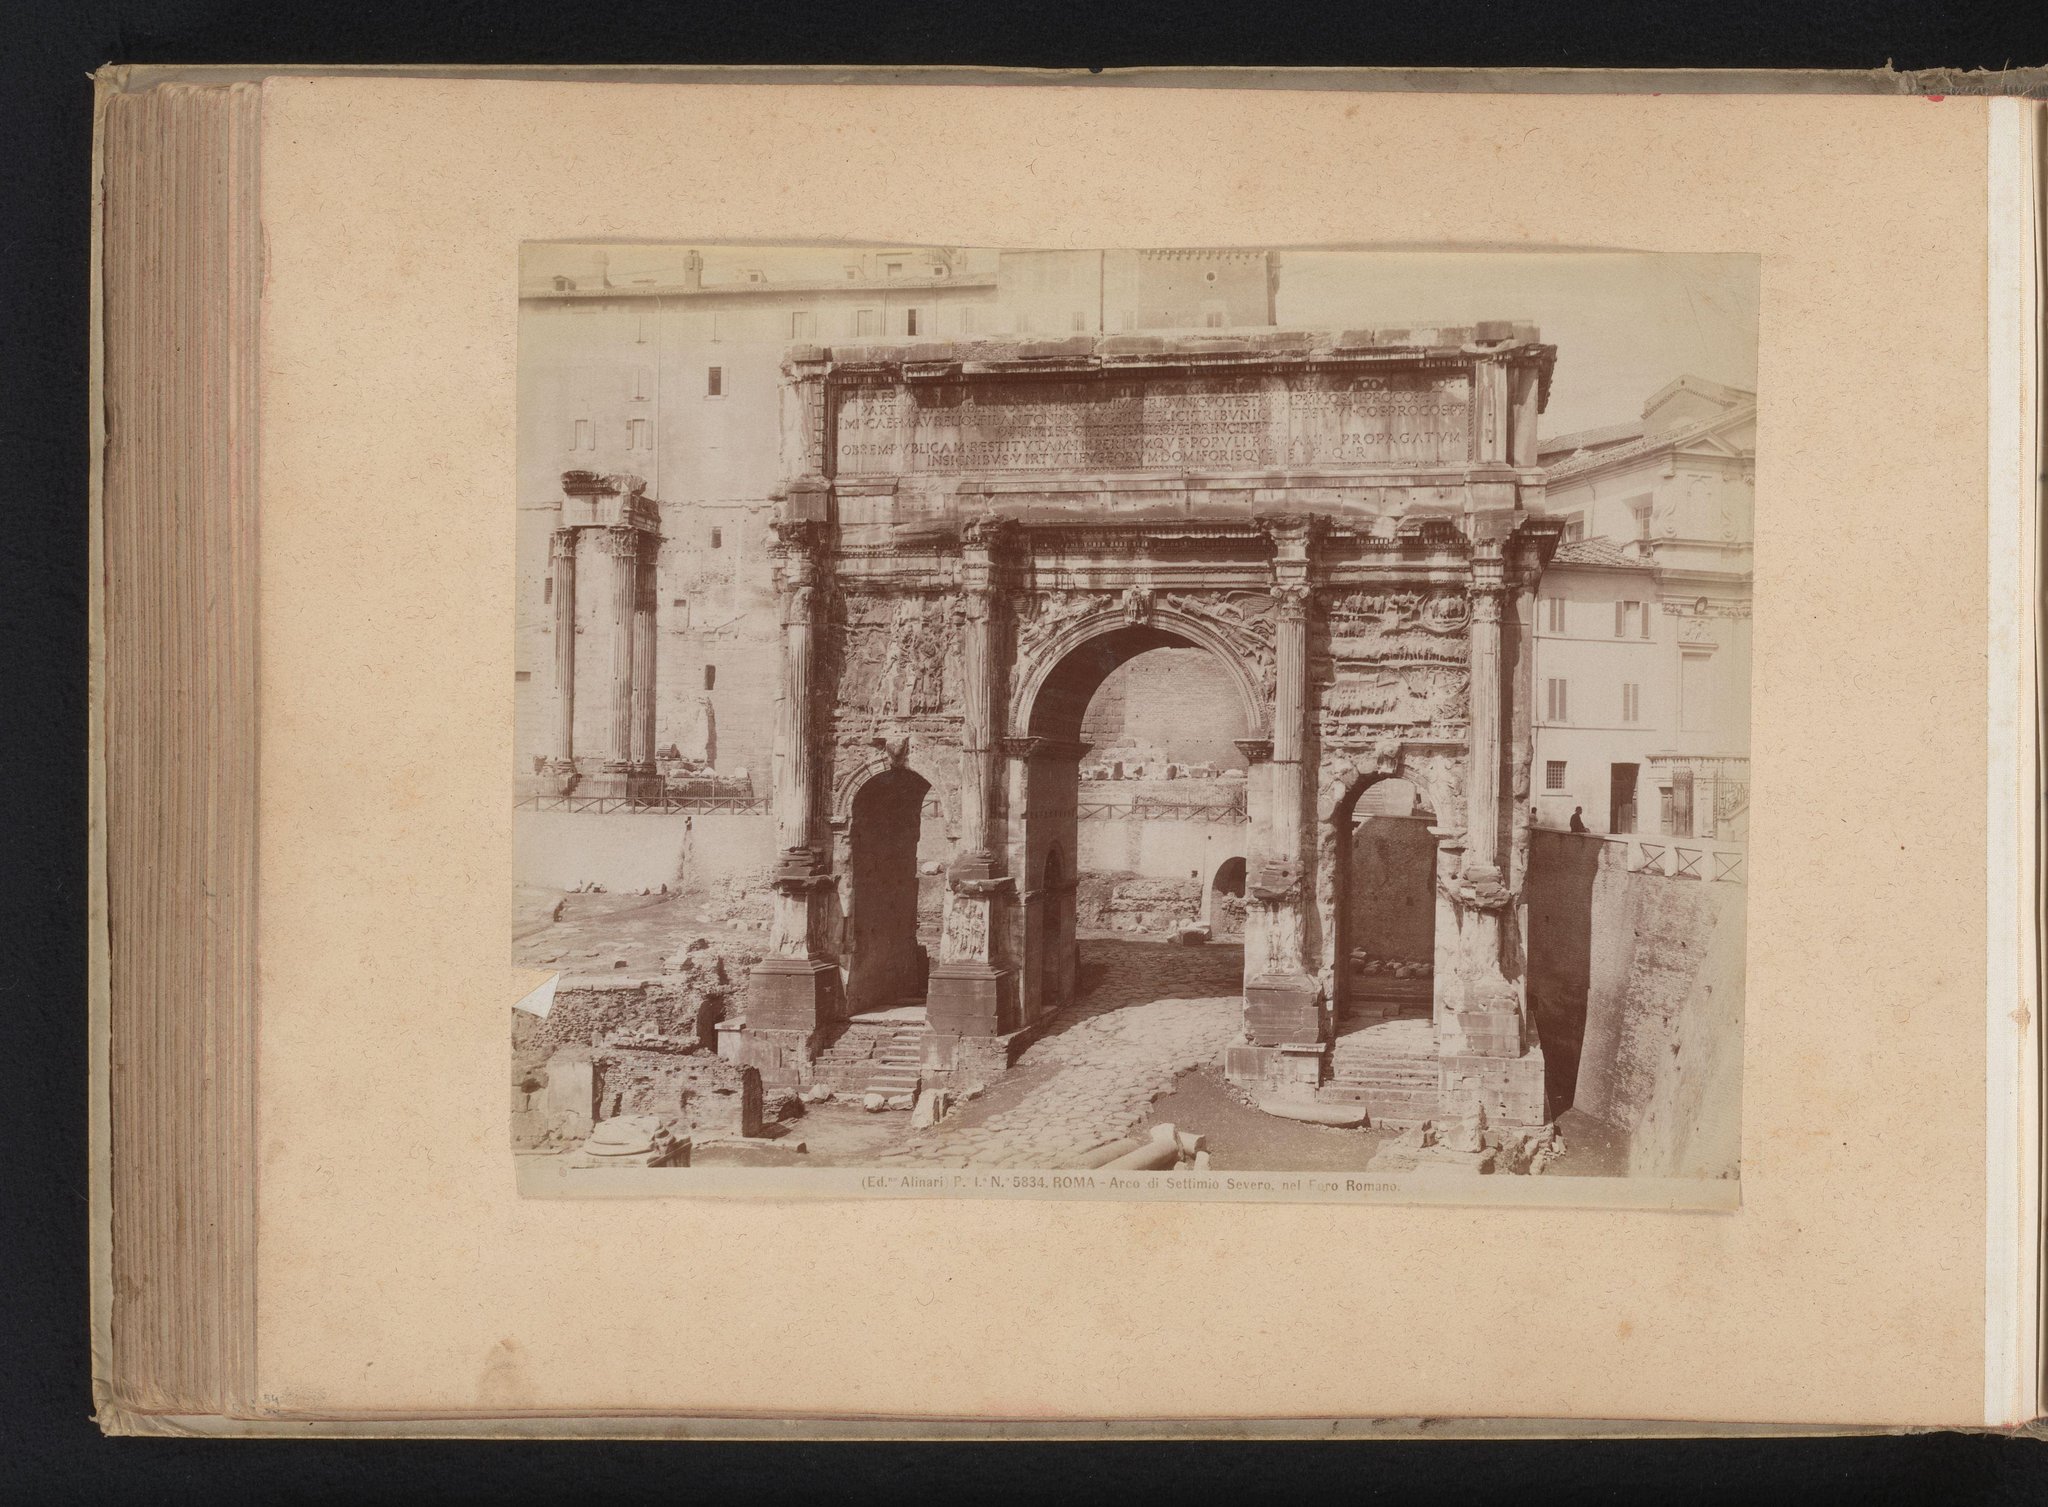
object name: photograph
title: Gezicht op de Boog van Septimius Severus op het Forum Romanum in Rome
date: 1870-1895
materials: cardboard, photographic support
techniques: albumen print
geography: rome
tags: triumphal arch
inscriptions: inscription: ‘(Ed.ne Alinari) P.a I.a N.o 5834. ROMA - Arco di Settimio Severo, nel Foro Romano.’